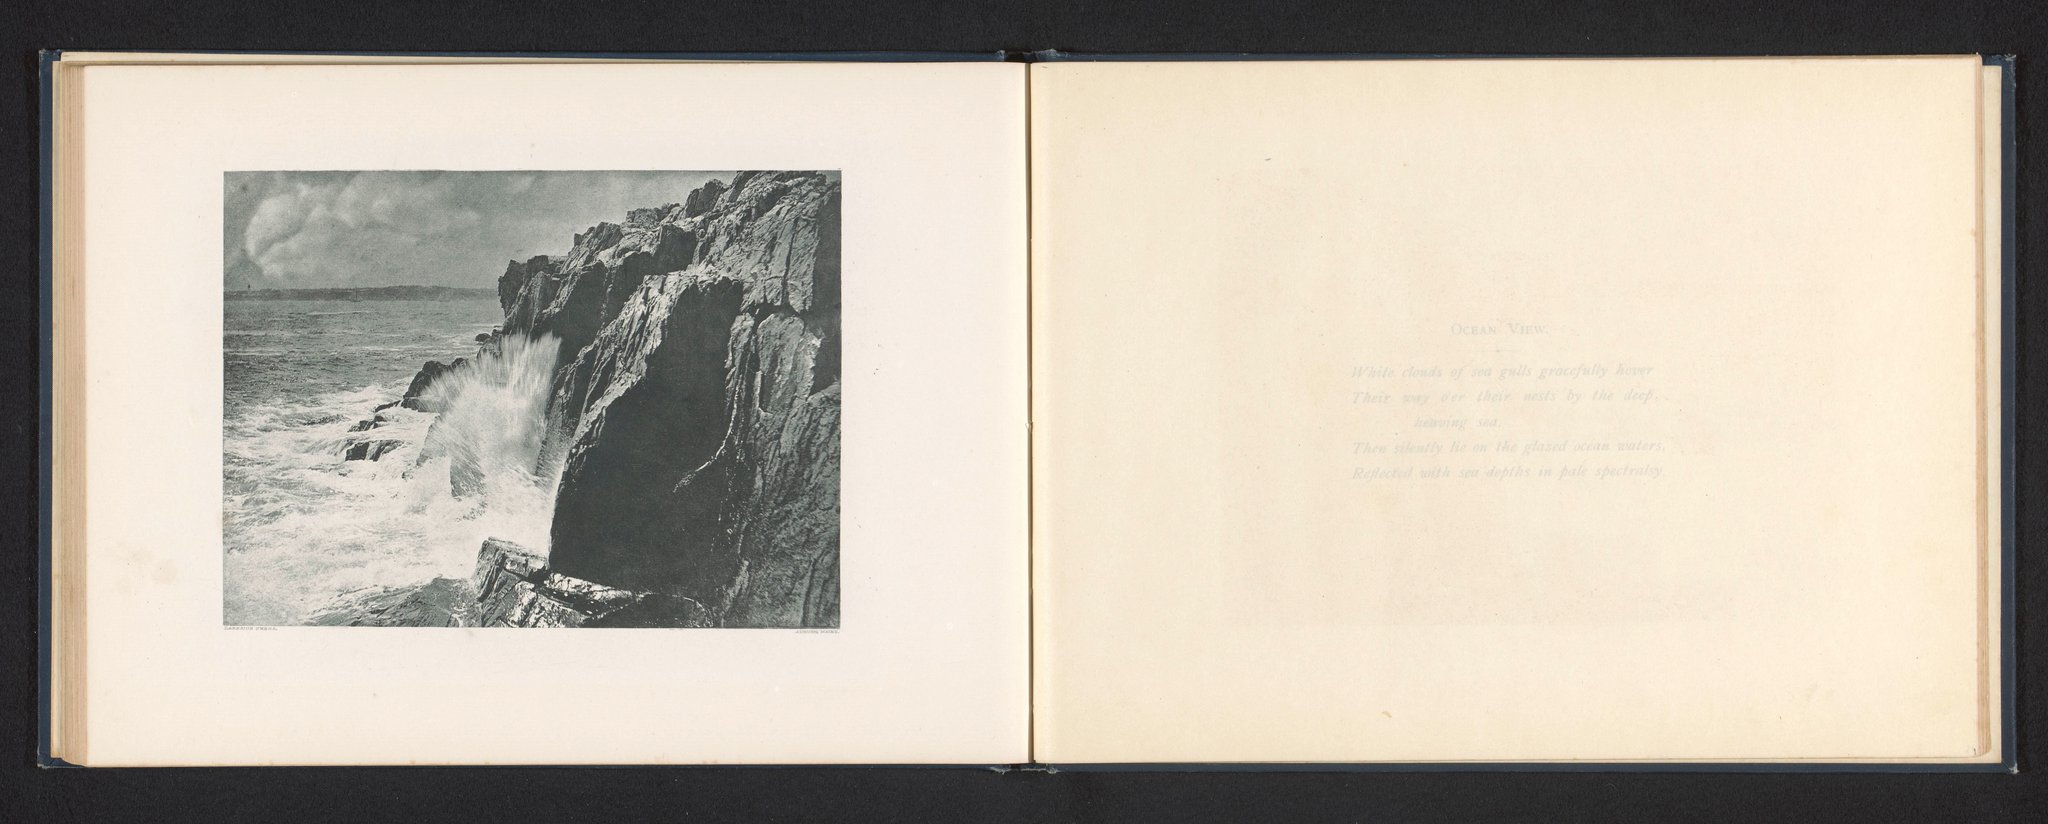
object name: photomechanical print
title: Gezicht op een klif waar water tegen aanslaat in Maine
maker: Anonymous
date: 1880-1890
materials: paper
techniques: photoaquatint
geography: maine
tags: coastal cliff or crag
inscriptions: inscription: ‘Ocean View. (...)’